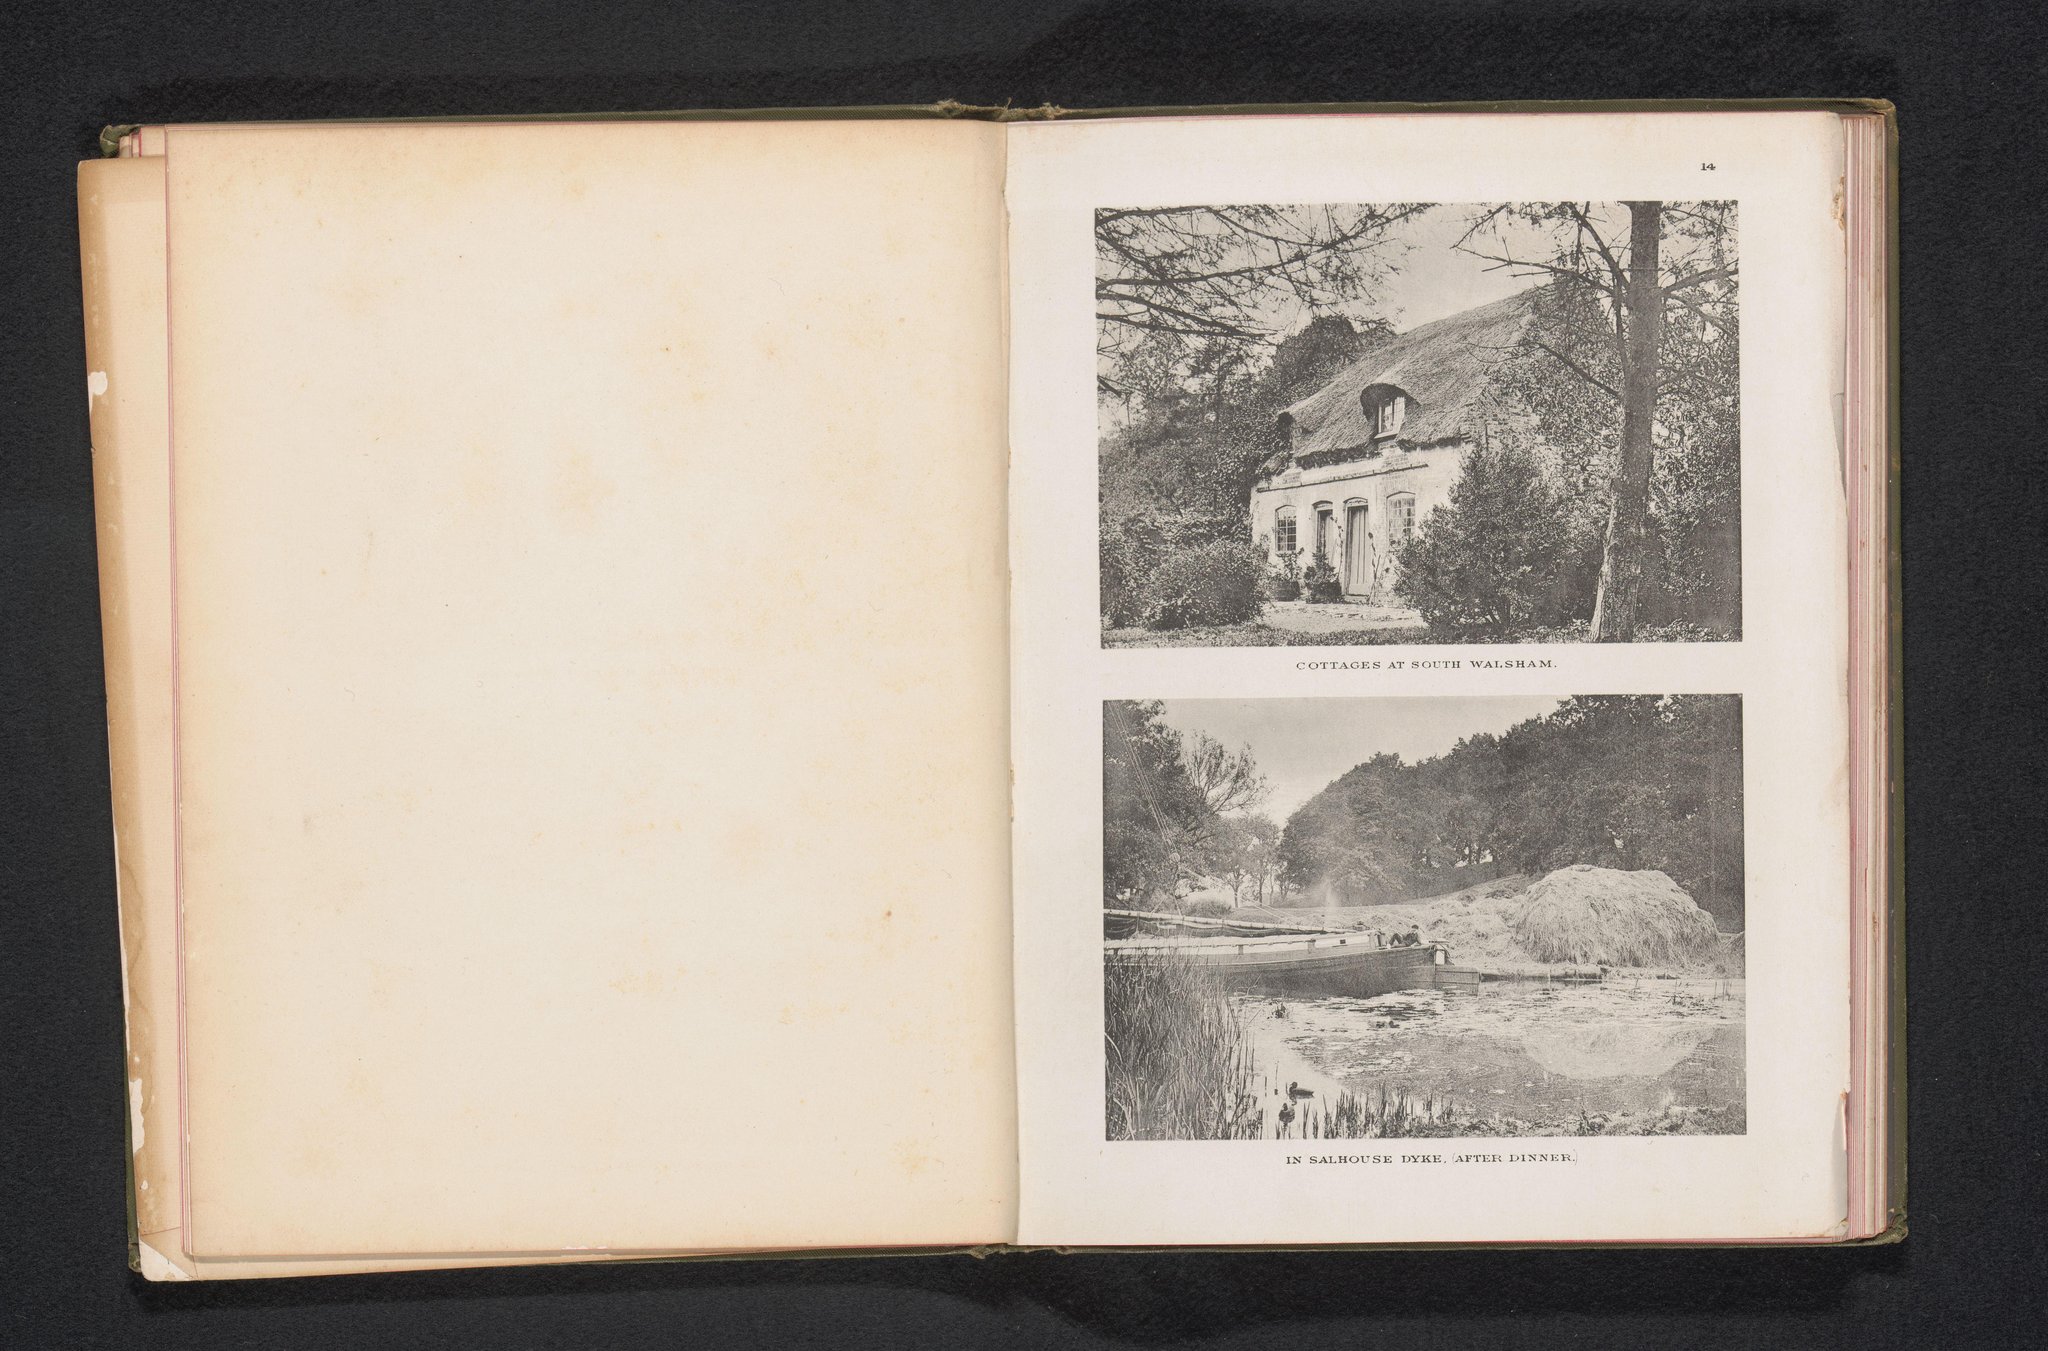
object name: page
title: Gezicht op een huis in South Walsham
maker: john payne jennings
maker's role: fotograaf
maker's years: 1843-1926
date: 1886-1891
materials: paper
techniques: photograph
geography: surrey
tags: façade (of house or building)